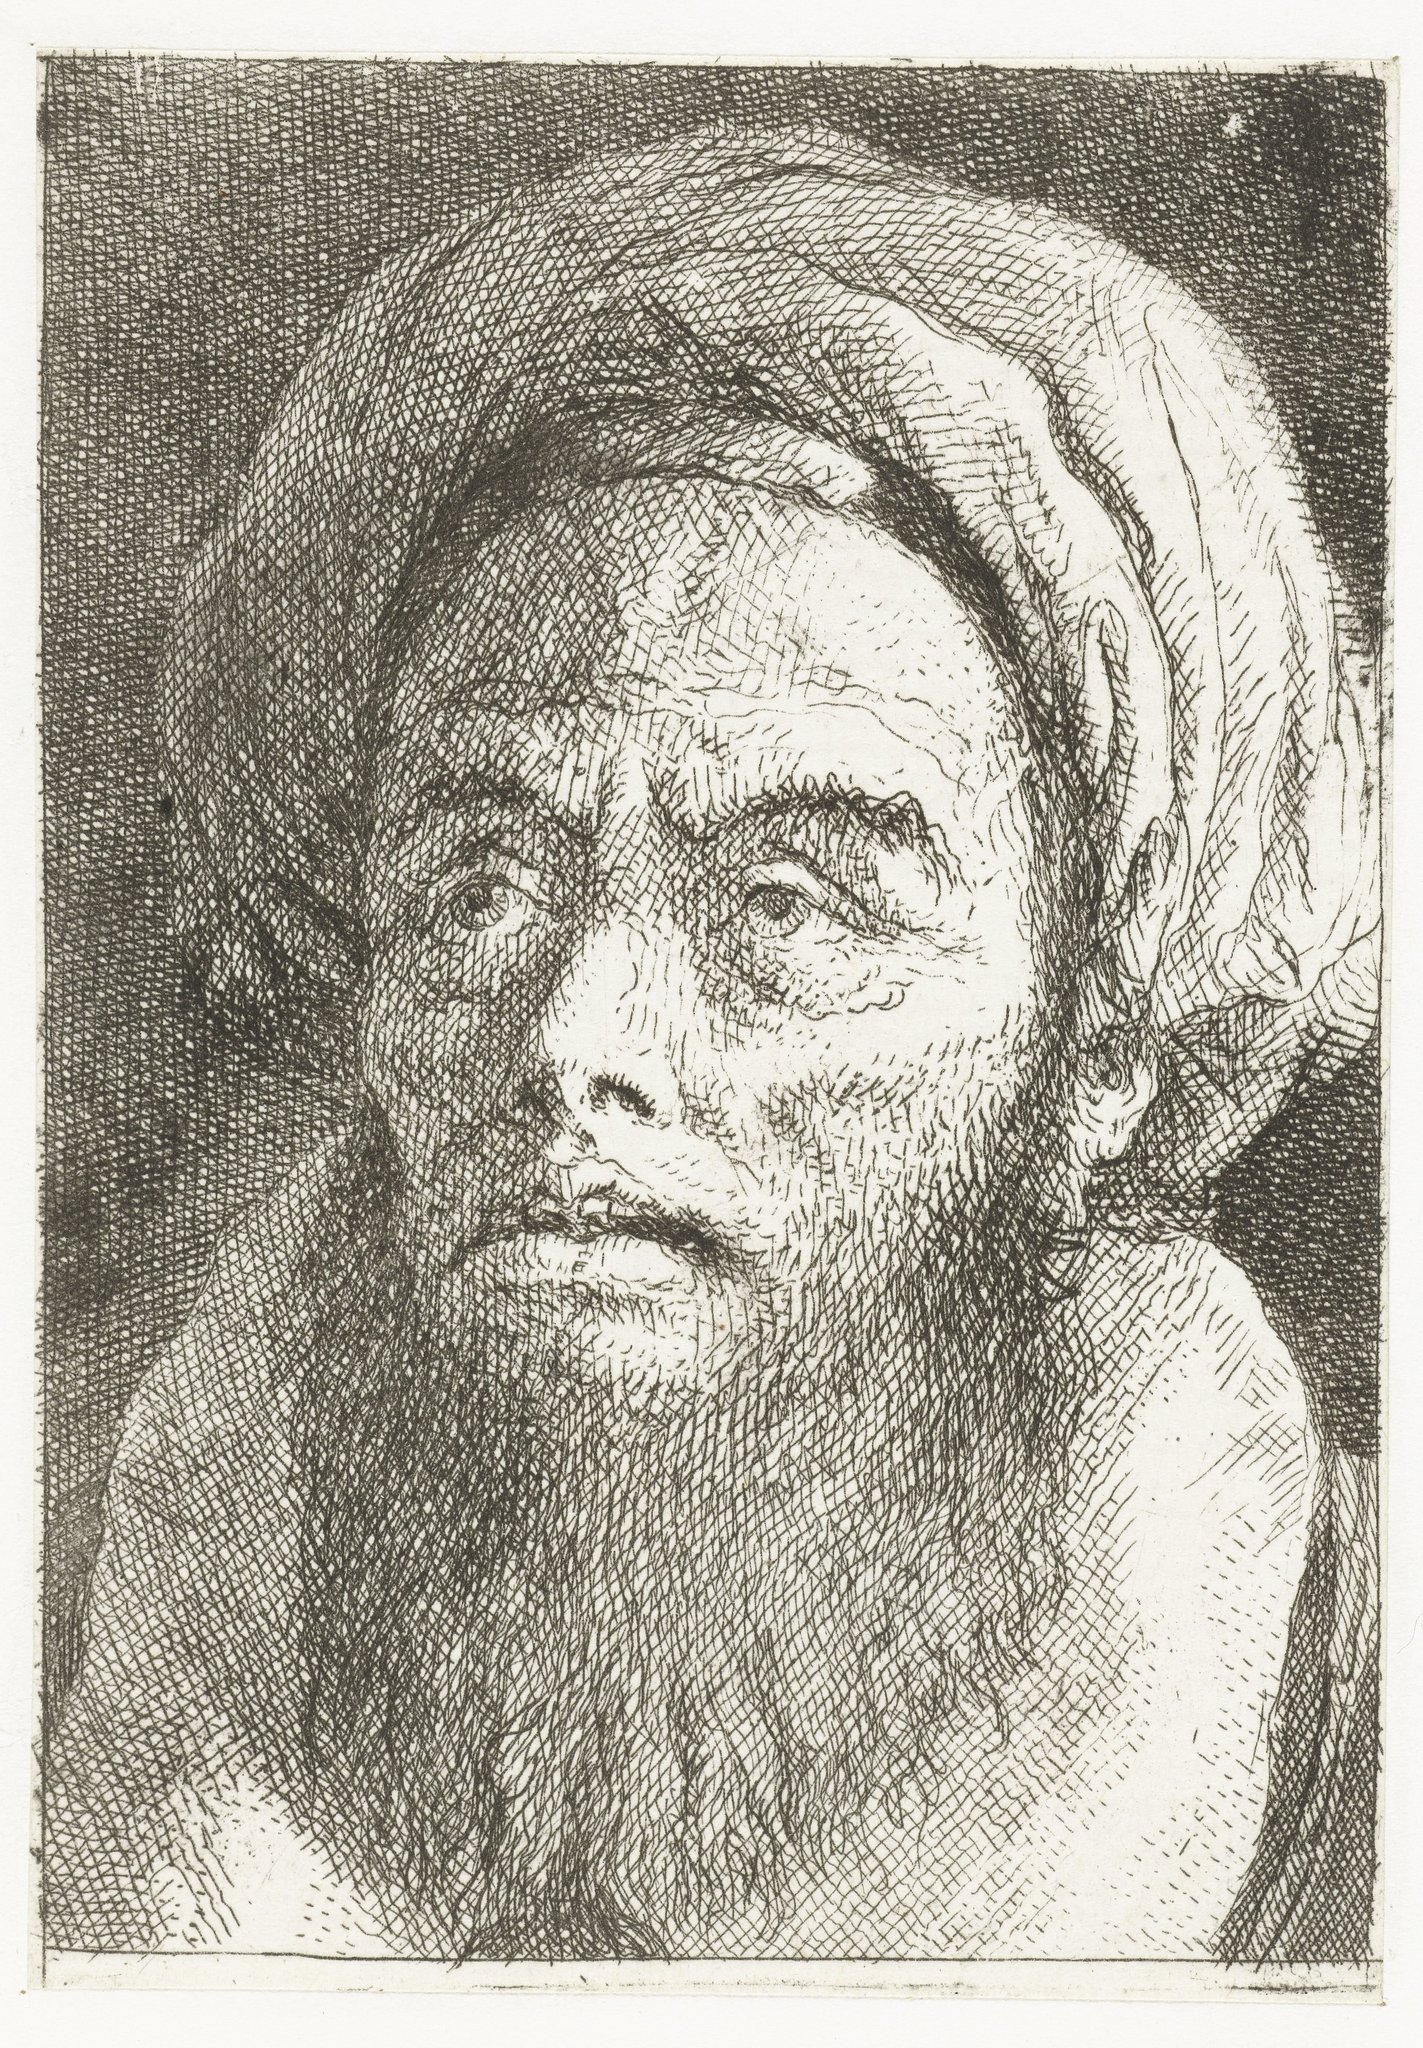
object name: print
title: Man met tulband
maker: giovanni domenico tiepolo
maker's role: draughtsman, print maker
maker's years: 1727-1804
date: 1771-1774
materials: paper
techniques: etching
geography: venice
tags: head-gear: turban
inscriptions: collector's mark: Lugt 2228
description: Prent uit serie Verzameling hoofden (Raccolta di teste). Giovanni Domenico Tiepolo vervaardigde in de winter van 1757-1758 en in de periode van 1771-1774 deze hoofden naar schilderijen en tekeningen van Giovanni Battista Tiepolo. De eerste uitgave verscheen in 1774 in twee delen met elk dertig prenten. Deze prent werd in de tweede staat met serienummer 14 opgenomen in deel 2.